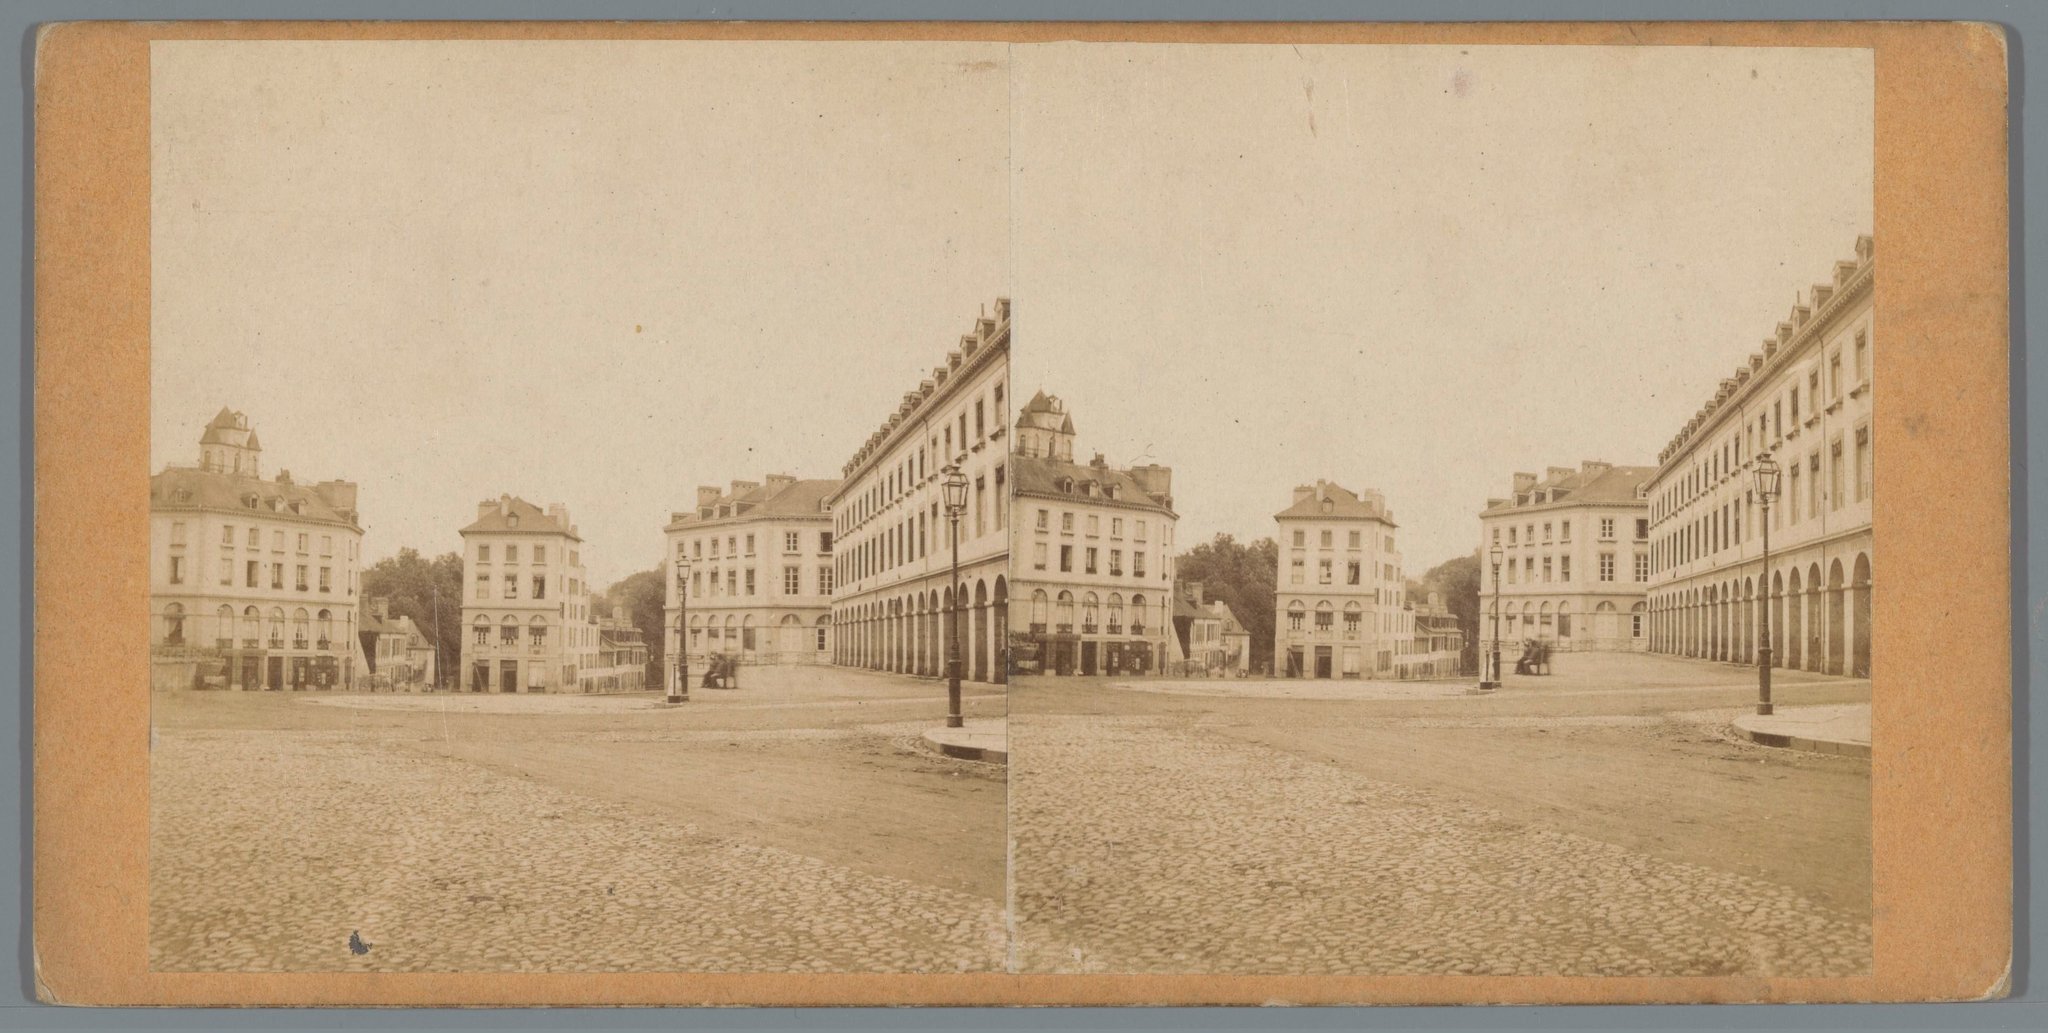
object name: stereograph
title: Gezicht op een plein, vermoedelijk in Parijs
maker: Anonymous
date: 1850-1880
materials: cardboard, photographic support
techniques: albumen print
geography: paris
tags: square, place, circus, etc., paris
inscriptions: inscription: ‘Place Grammont’, number: ‘169 49 35 cs [...] 49’